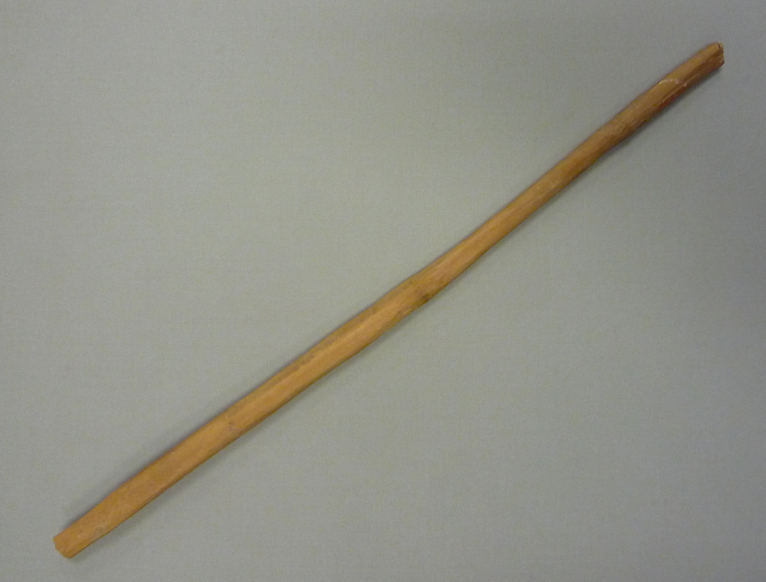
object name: model lever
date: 1479-1458 BCE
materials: wood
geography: egypt